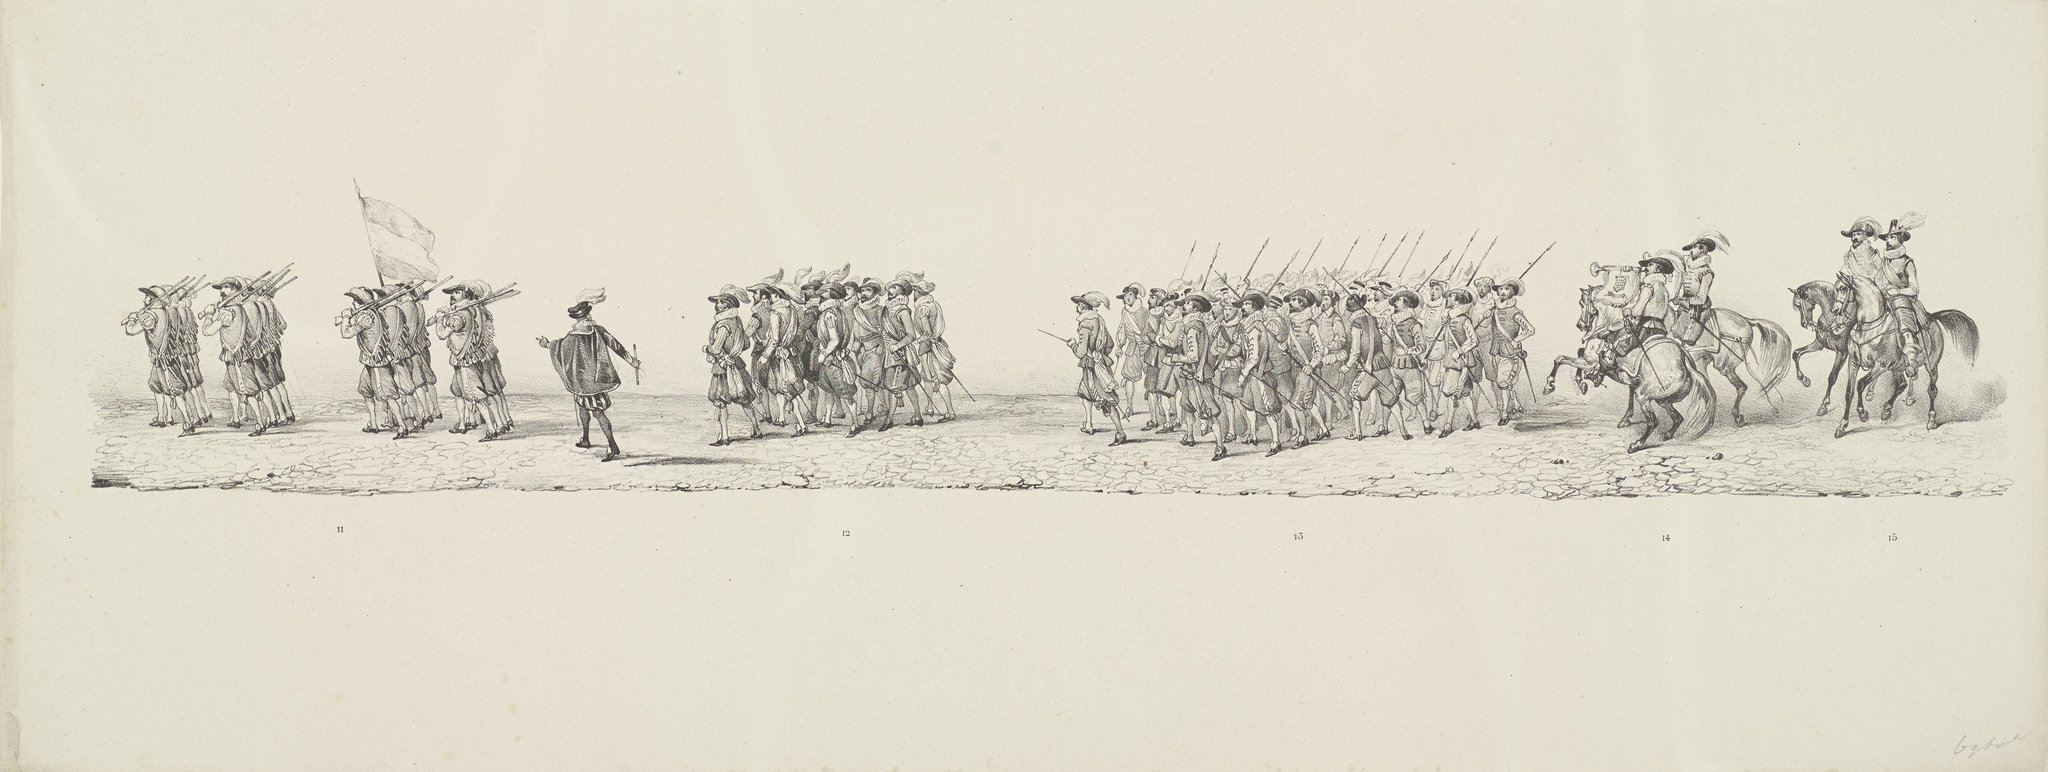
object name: print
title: Historische optocht bij het tweede eeuwfeest van de Utrechtse Hogeschool, 1836 (plaat 4)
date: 1837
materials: paper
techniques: lithograph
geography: utrecht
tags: students' pageant, costumes used in pageants, battle of nieuwpoort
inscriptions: collector's mark: Lugt 2228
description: Historische gekostumeerde optocht van de studenten van de Hogeschool van Utrecht op 16 juni 1836, bij de viering van het tweede eeuwfeest van de Utrechtse Hogeschool. De optocht verbeeldt de intocht van het Staatse leger in Oostende op 3 juli 1600, daags na de overwinning in de Slag bij Nieuwpoort. Vierde plaat in een serie van tien ongenummerde platen, met de groepen genummerd 11-15